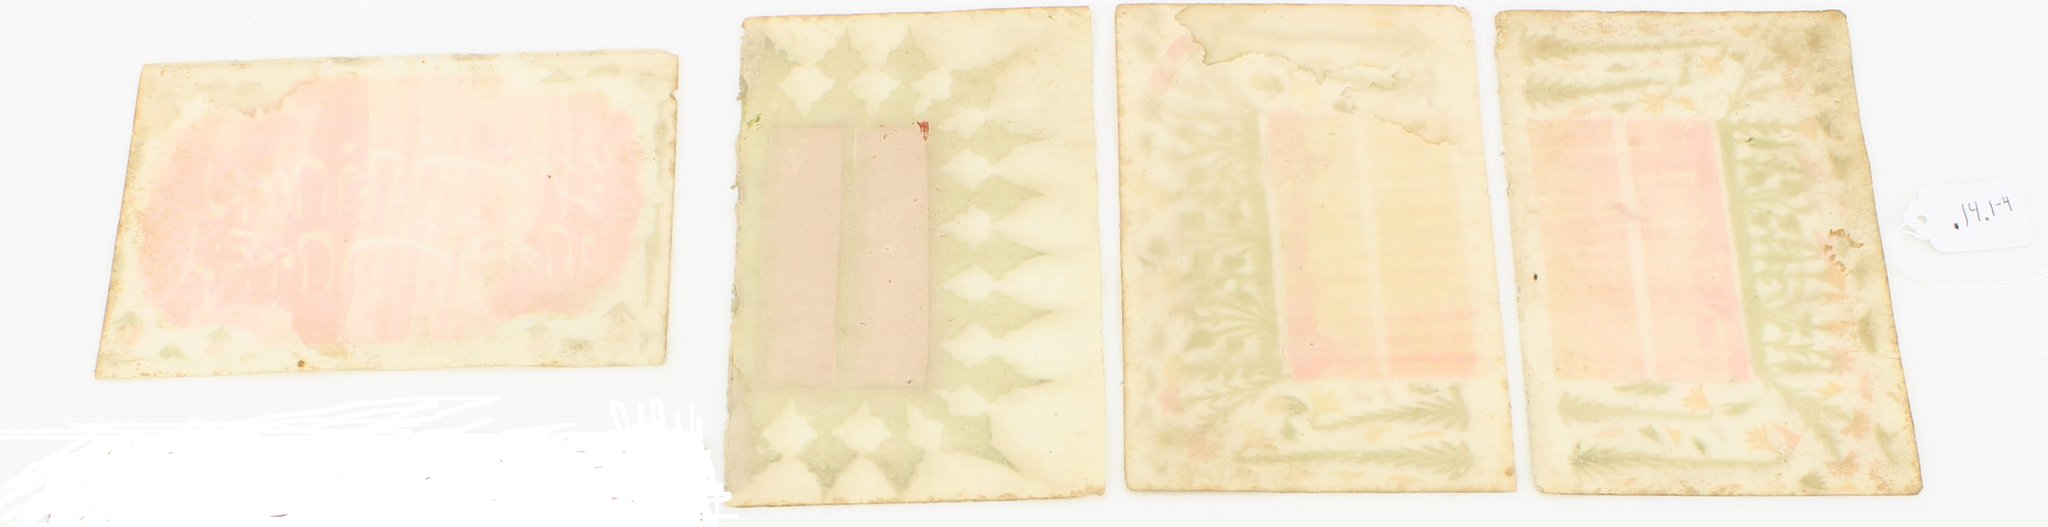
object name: folio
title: Group of Four Decorated Folios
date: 1701-1900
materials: paper, watercolor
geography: iran